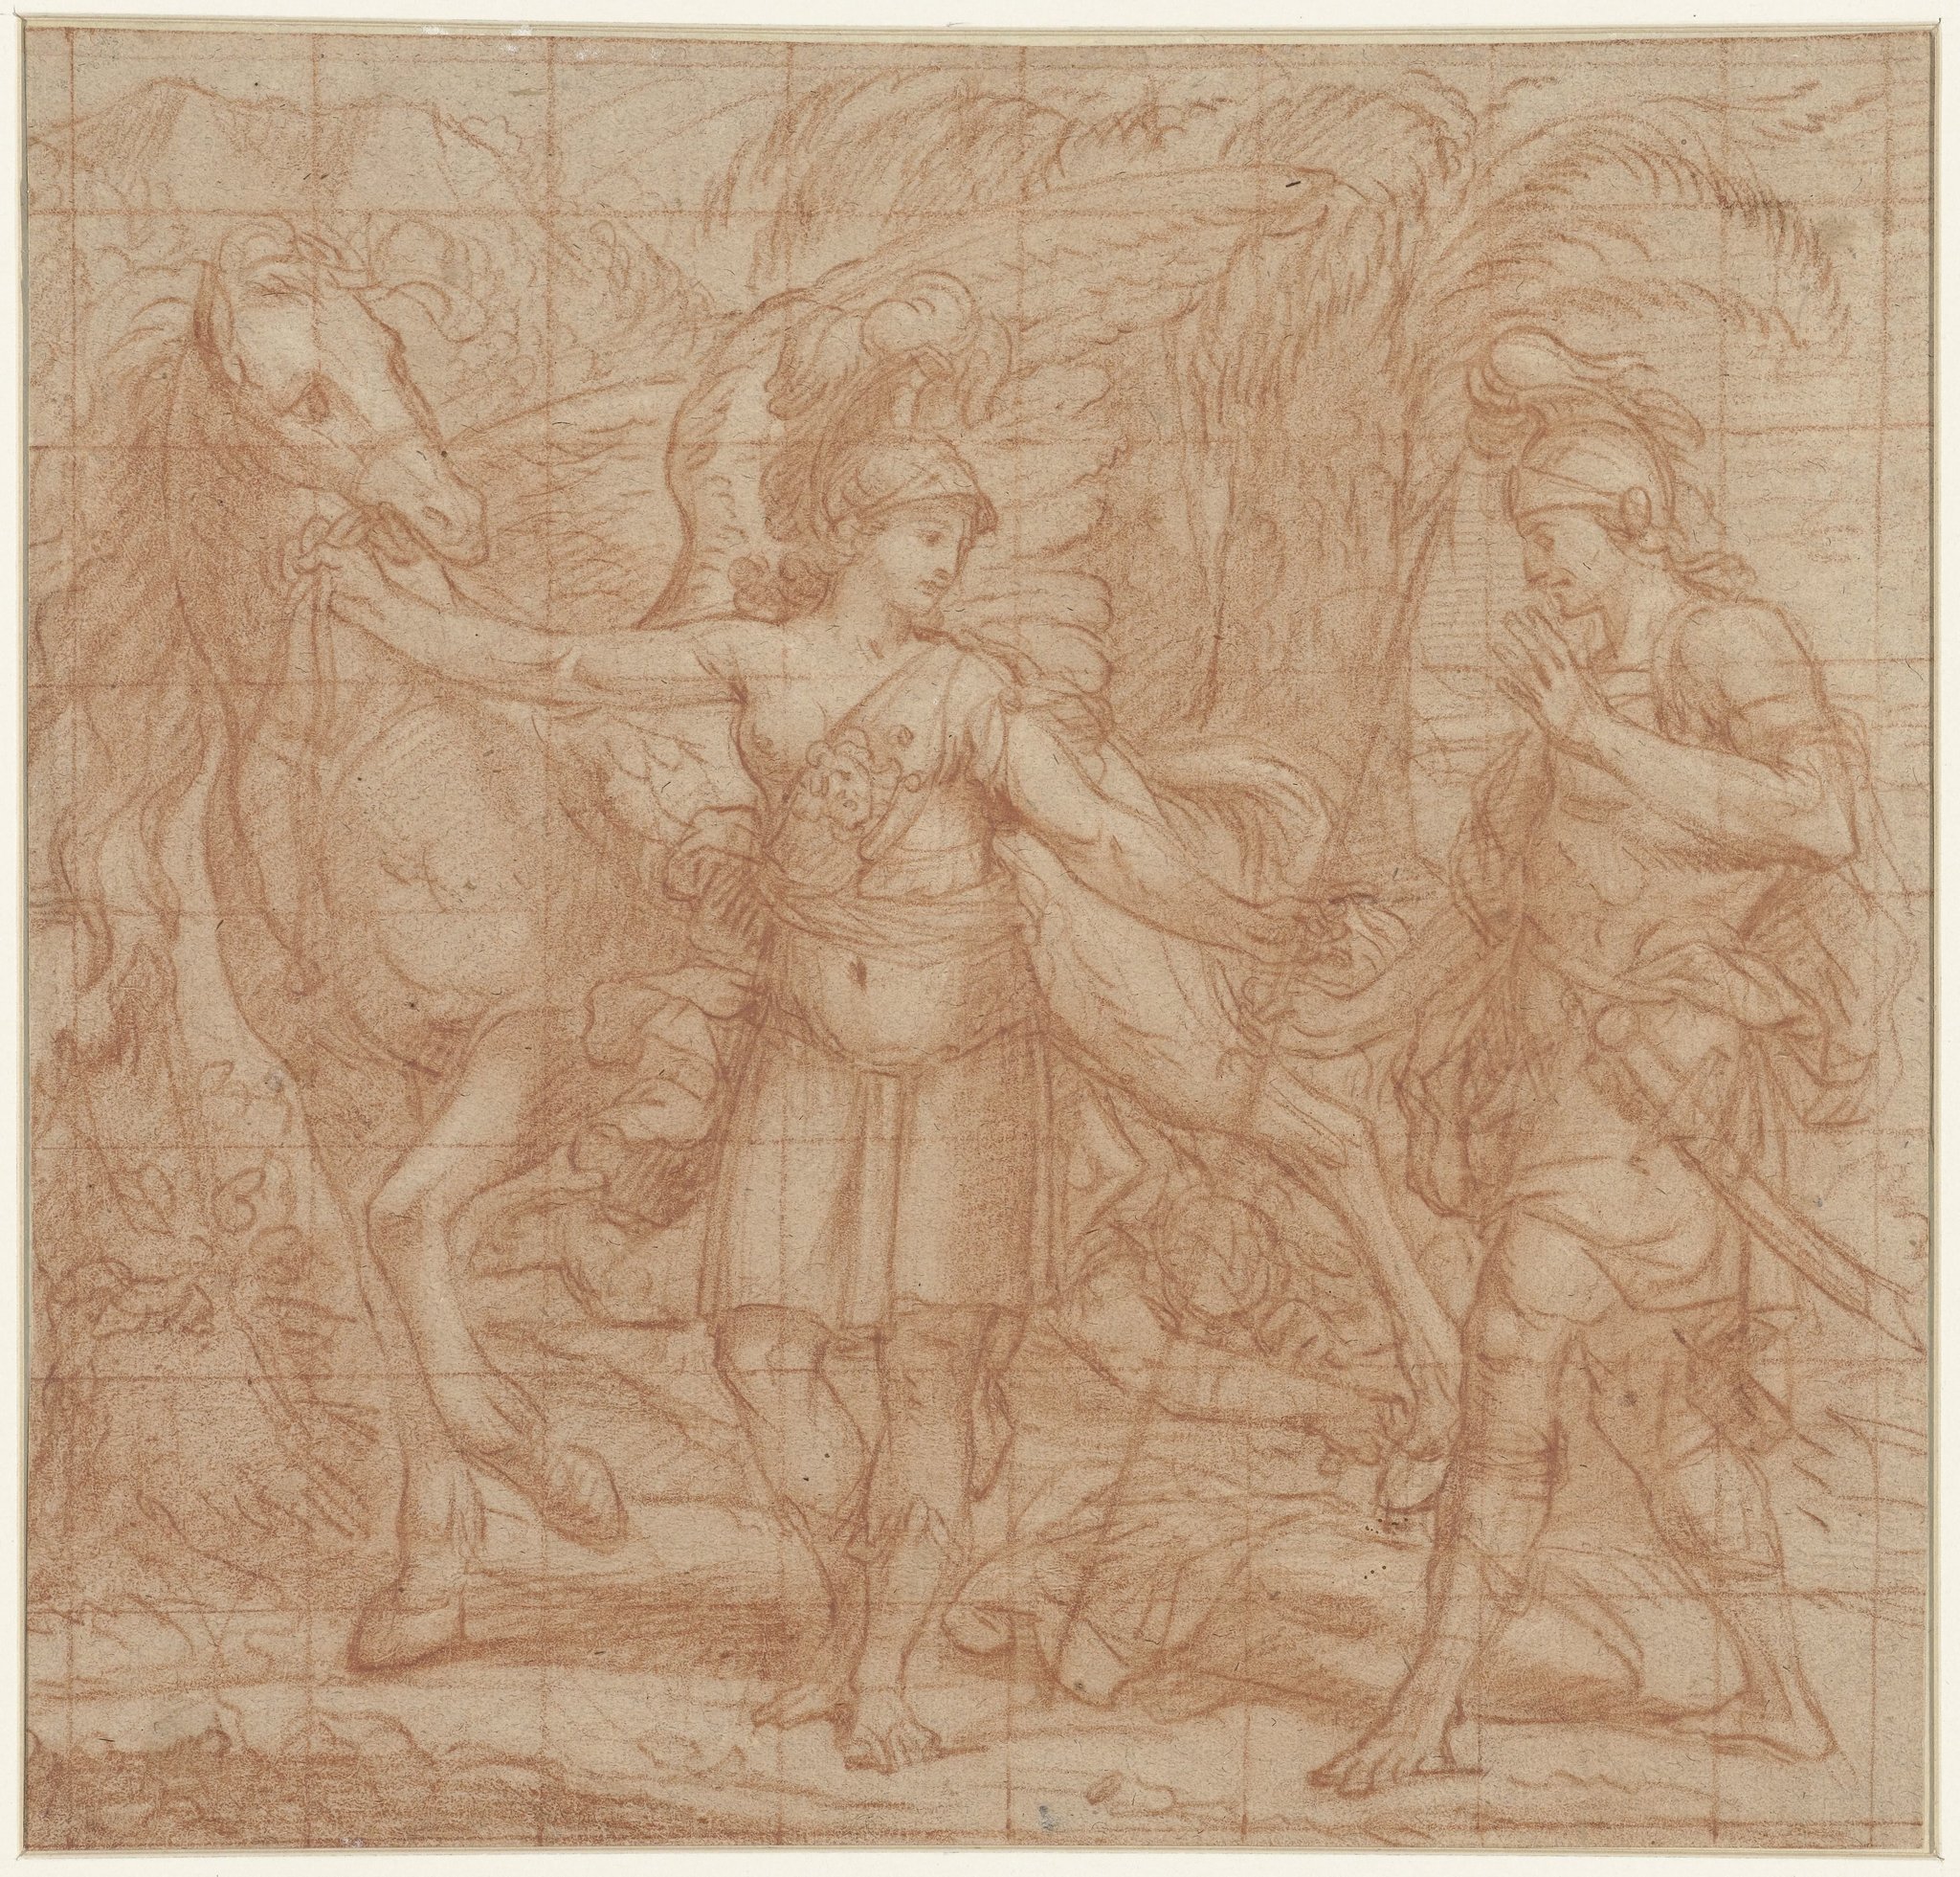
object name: drawing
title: Mythologische voorstelling met Minerva (?) en Pegasus (?)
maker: Anonymous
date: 1600-1699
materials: chalk, paper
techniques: drawing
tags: pegasus, the winged horse, (story of) minerva (pallas, athena)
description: Minerva schenkt de zopas getemde en gebreidelde Pegasus aan Bellerophon.